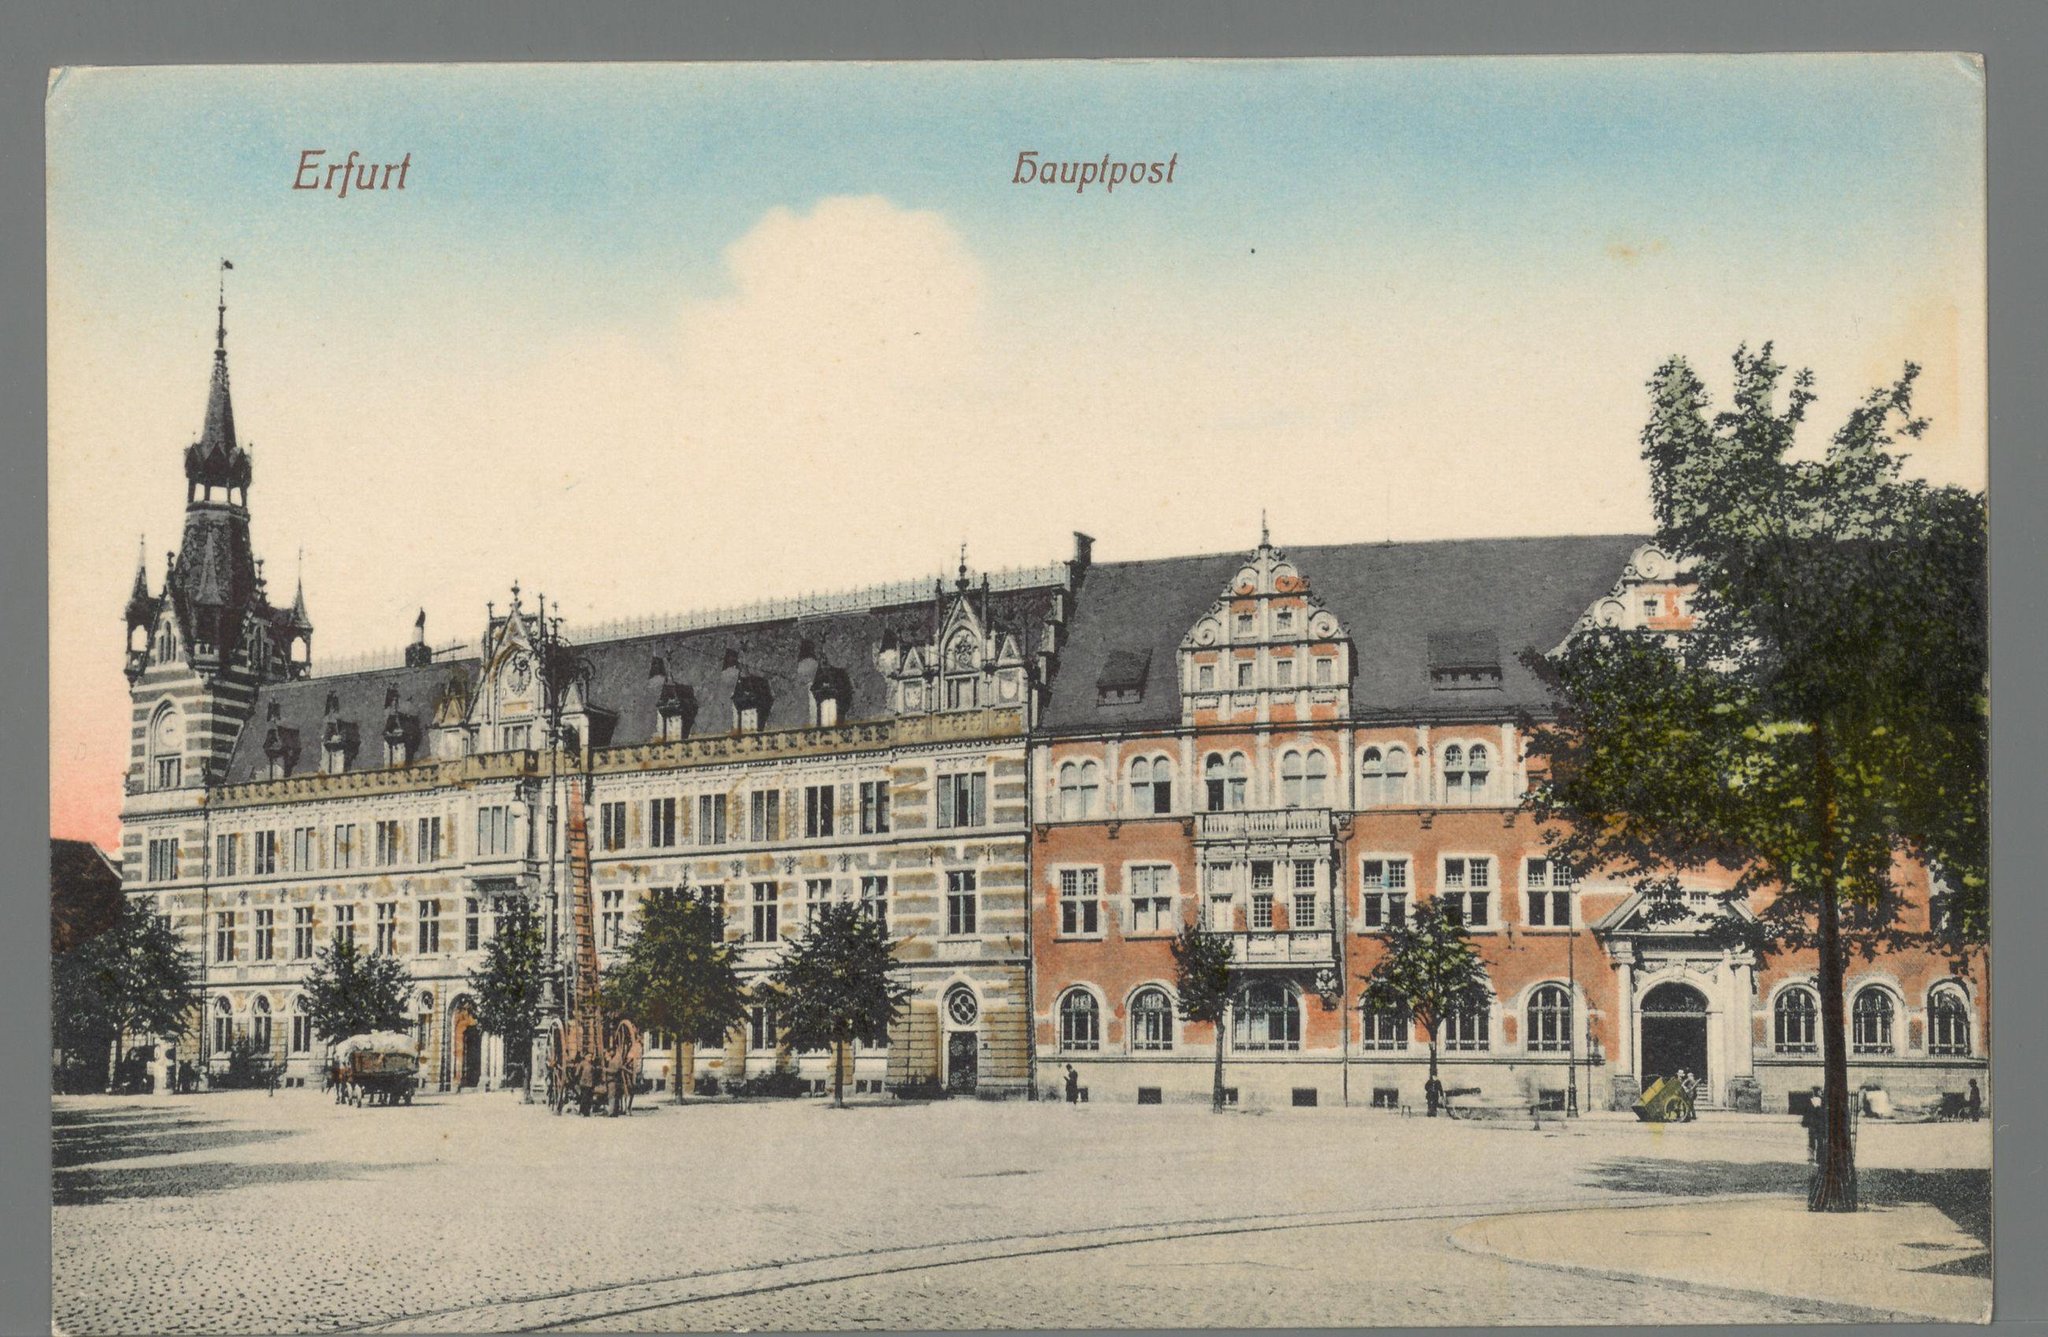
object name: ansichtkaart, prentbriefkaart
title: Erfurt. Hauptpost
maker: Anonymous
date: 1905-1930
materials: cardboard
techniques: photograph, lithograph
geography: dresden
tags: square, place, circus, etc., street